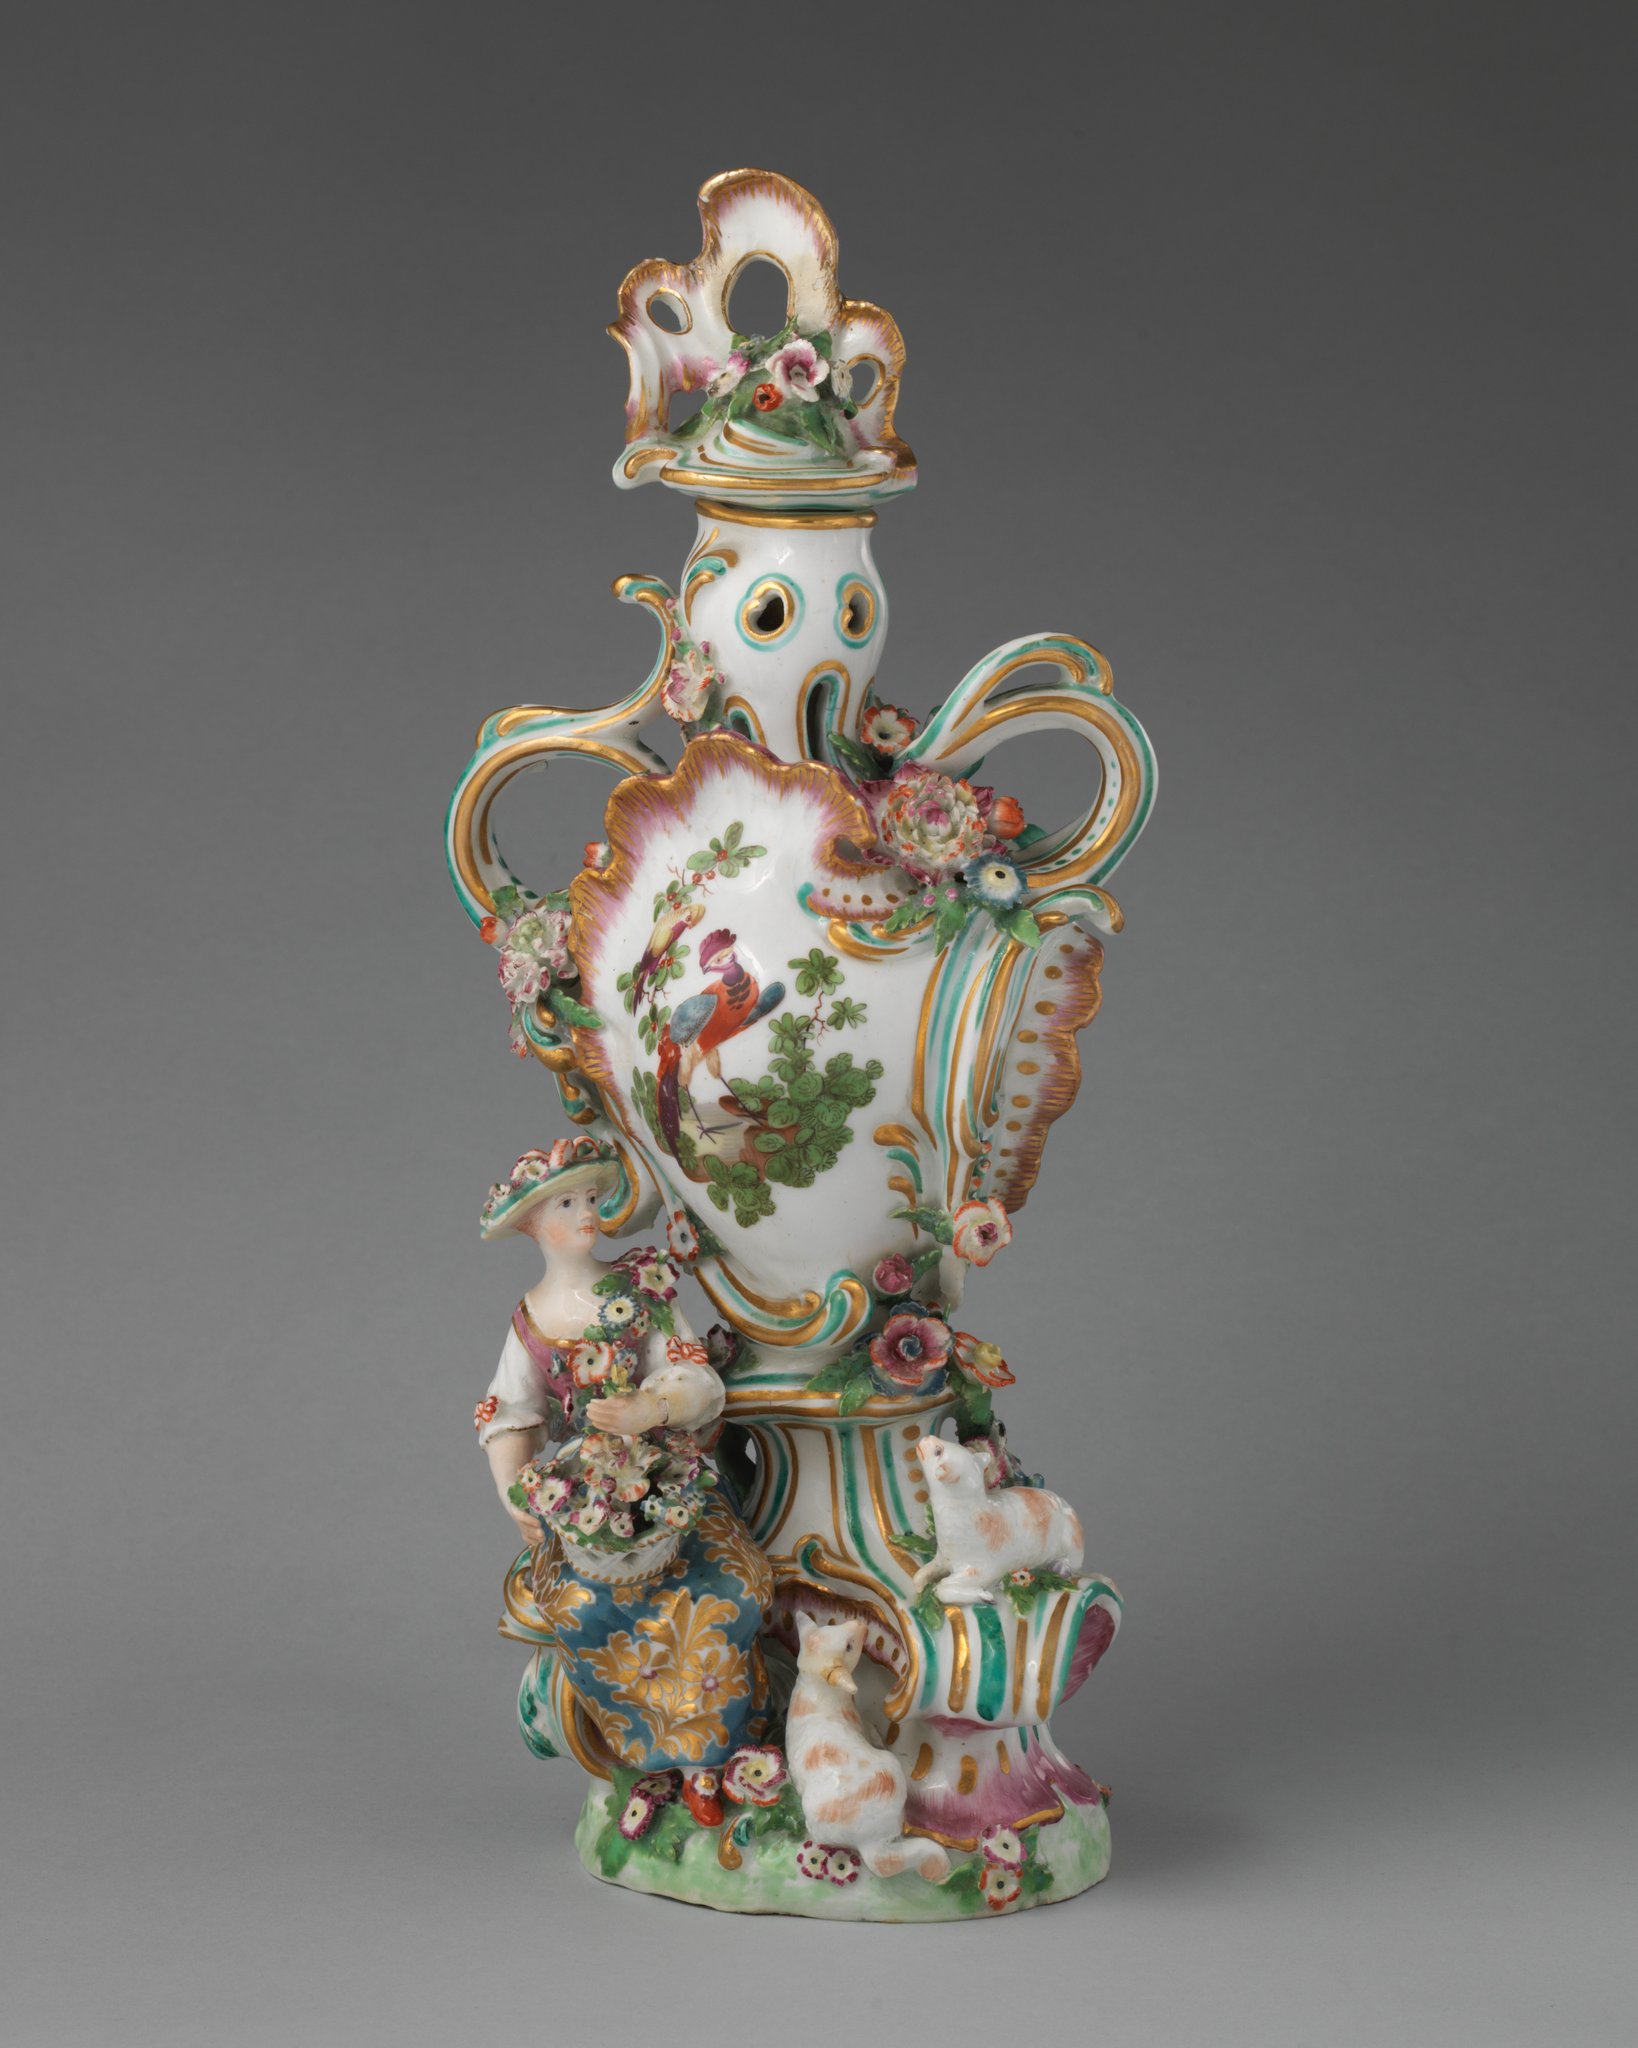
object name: vase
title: Vase (one of a pair)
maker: chelsea porcelain manufactory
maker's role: factory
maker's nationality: british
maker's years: 1744-1784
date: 1760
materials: soft paste porcelain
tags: animals,birds,flowers